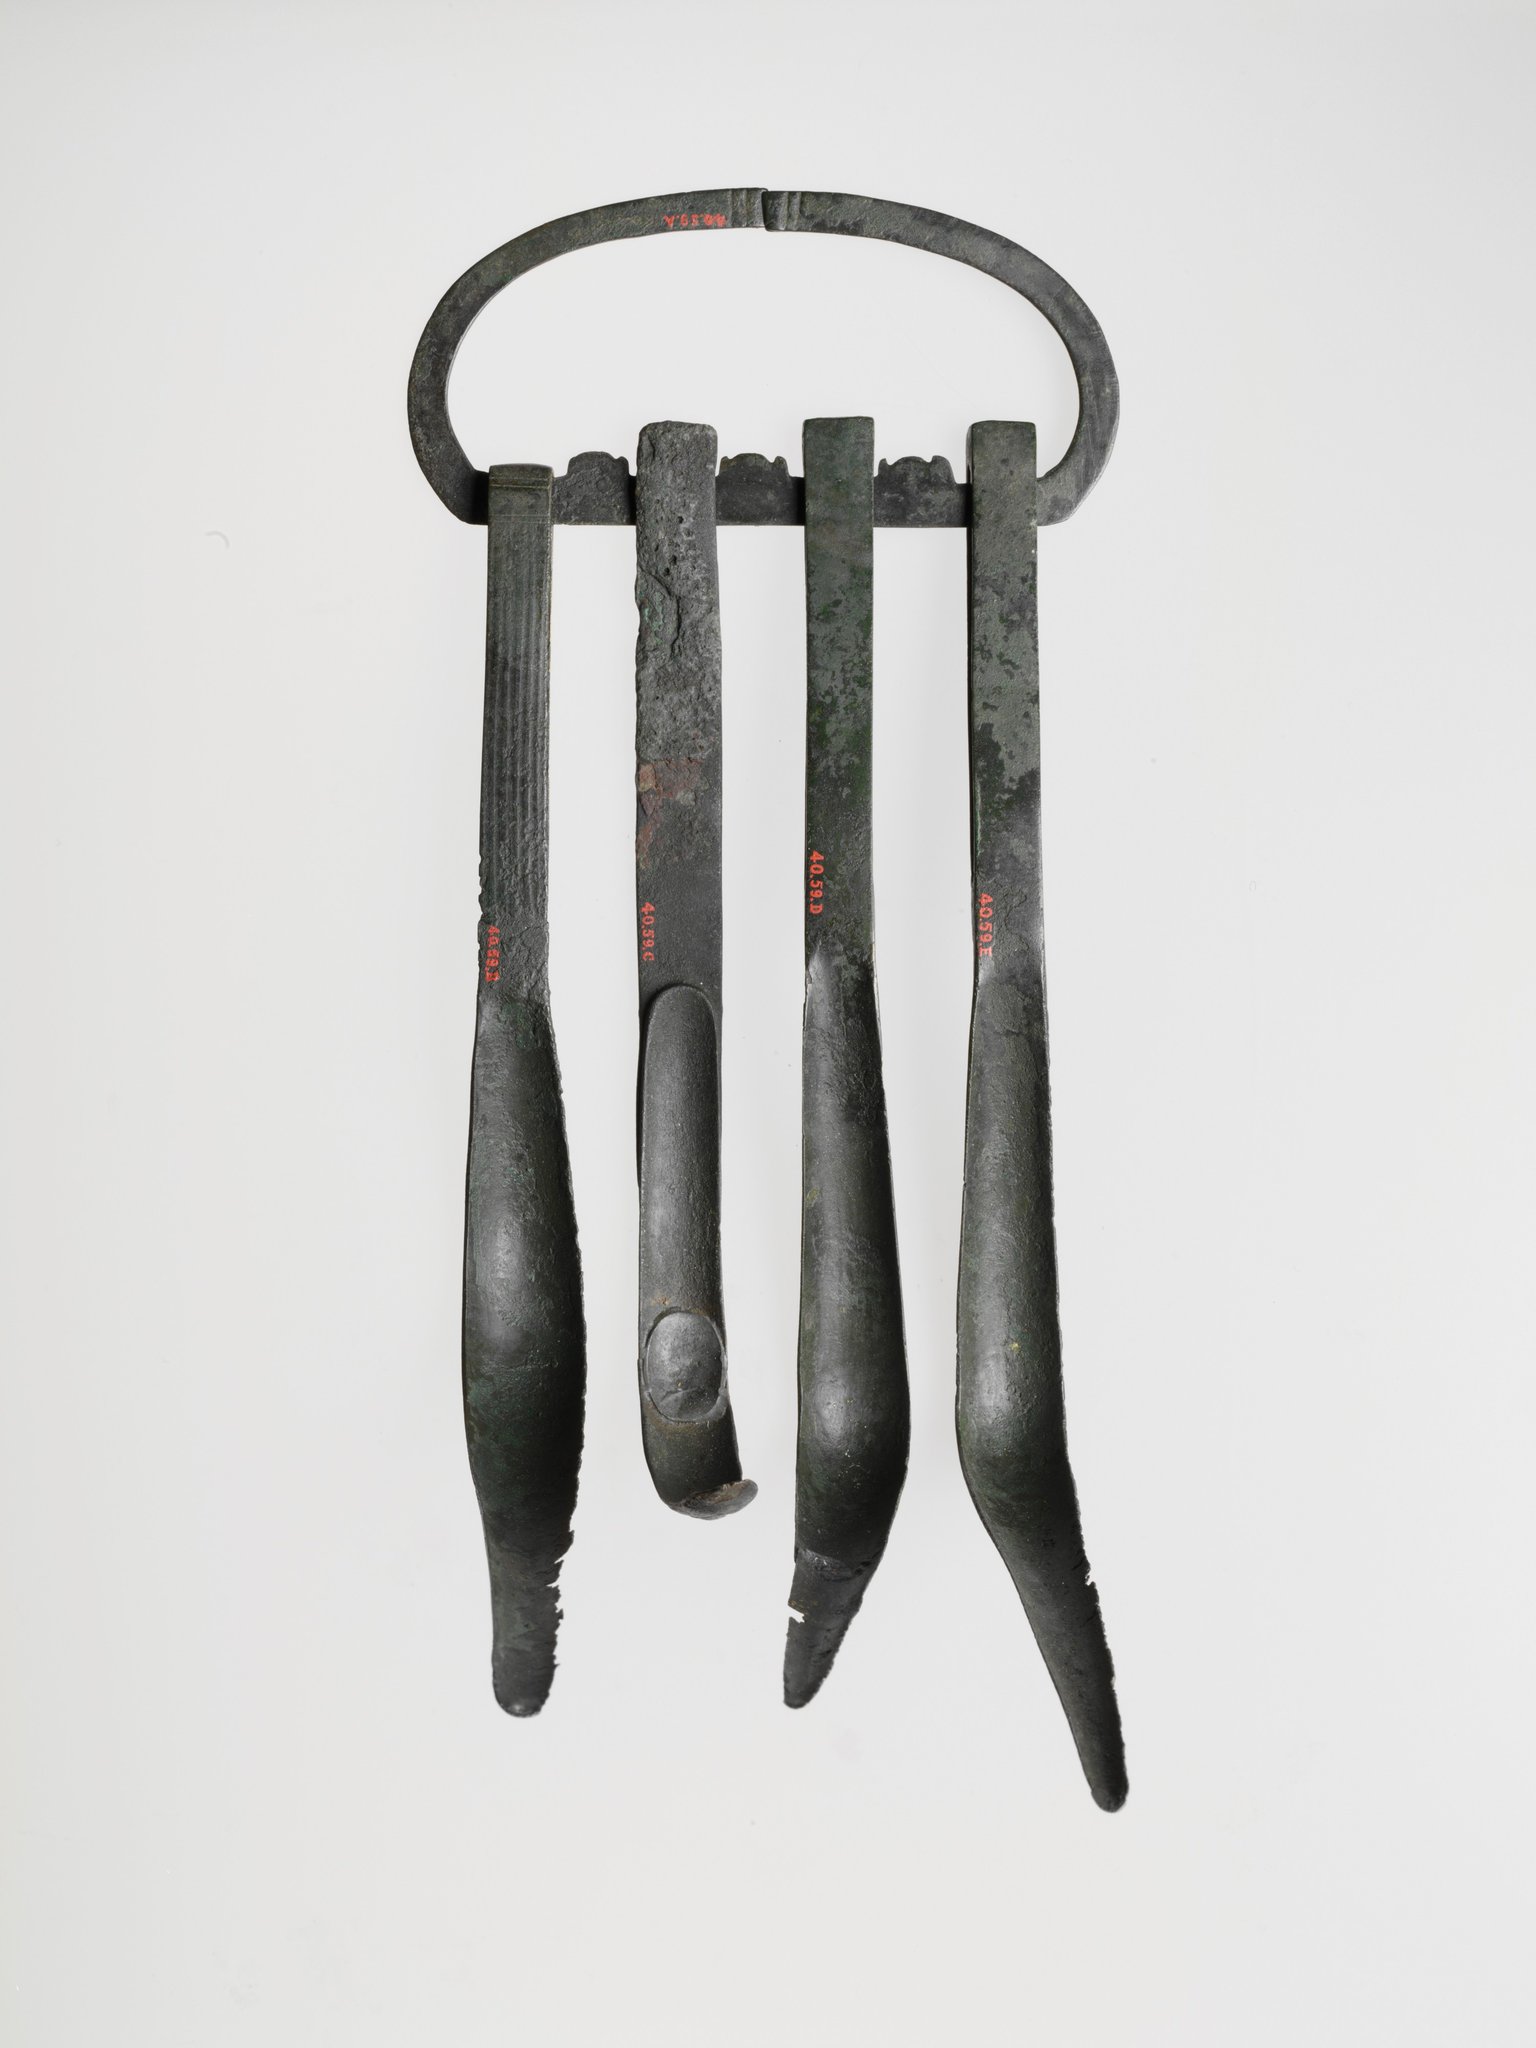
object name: strigils, 4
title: Set of bronze strigils and carrying ring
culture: roman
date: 100 BCE-200 CE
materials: bronze